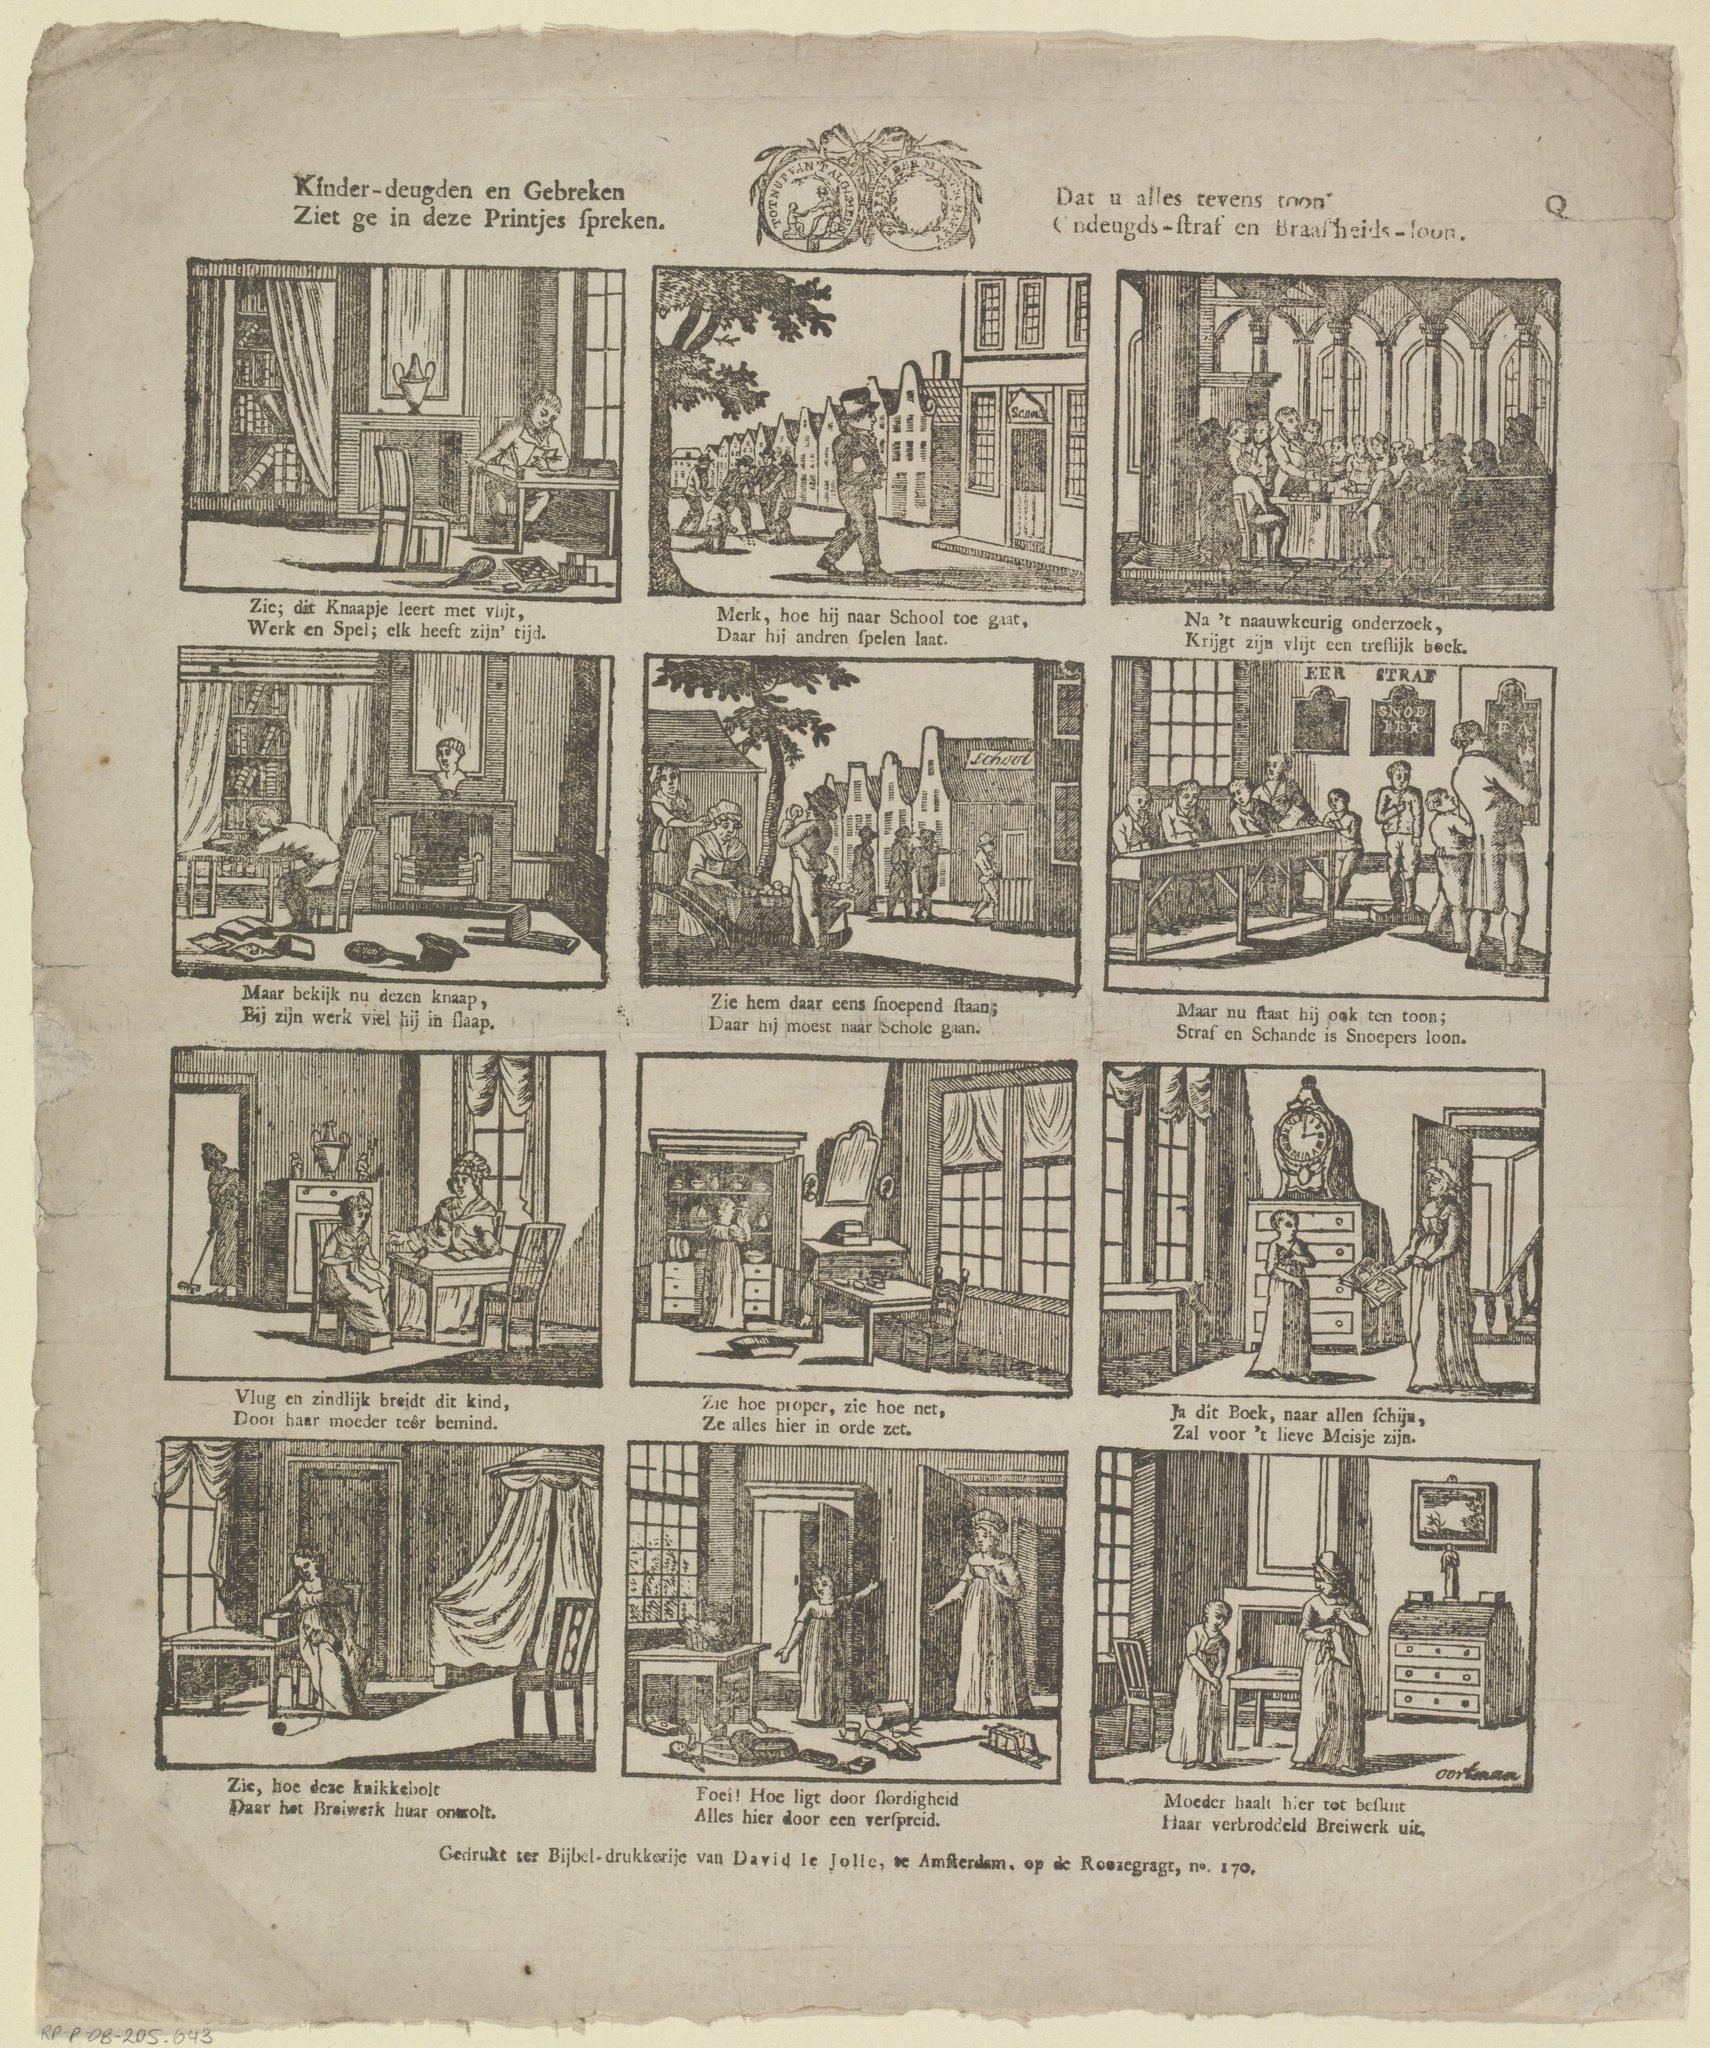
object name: print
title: Kinder-deugden en gebreken / Ziet ge in deze printjes spreken / Dat u alles tevens toon' / Ondeugds-straf en braafheids-loon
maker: david le jolle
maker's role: printer, publisher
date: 1814-1820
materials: paper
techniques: letterpress printing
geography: amsterdam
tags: tasks performed by children - aa - girl, bad habits - aa - girl, good and bad behaviour, moral qualities (opposing concepts) (+ situation or event (especially in genre-painting) with symbolical connotation), punishment at school, elementary school; class, form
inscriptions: collector's mark: Lugt 2760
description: Blad met 12 voorstellingen van de beloning van gehoorzame kinderen en de bestraffing van ongehoorzame kinderen. Midden boven het zegel van de Maatschappij tot Nut van 't Algemeen. Onder elke afbeelding een tweeregelig vers. Genummerd rechtsboven: Q.